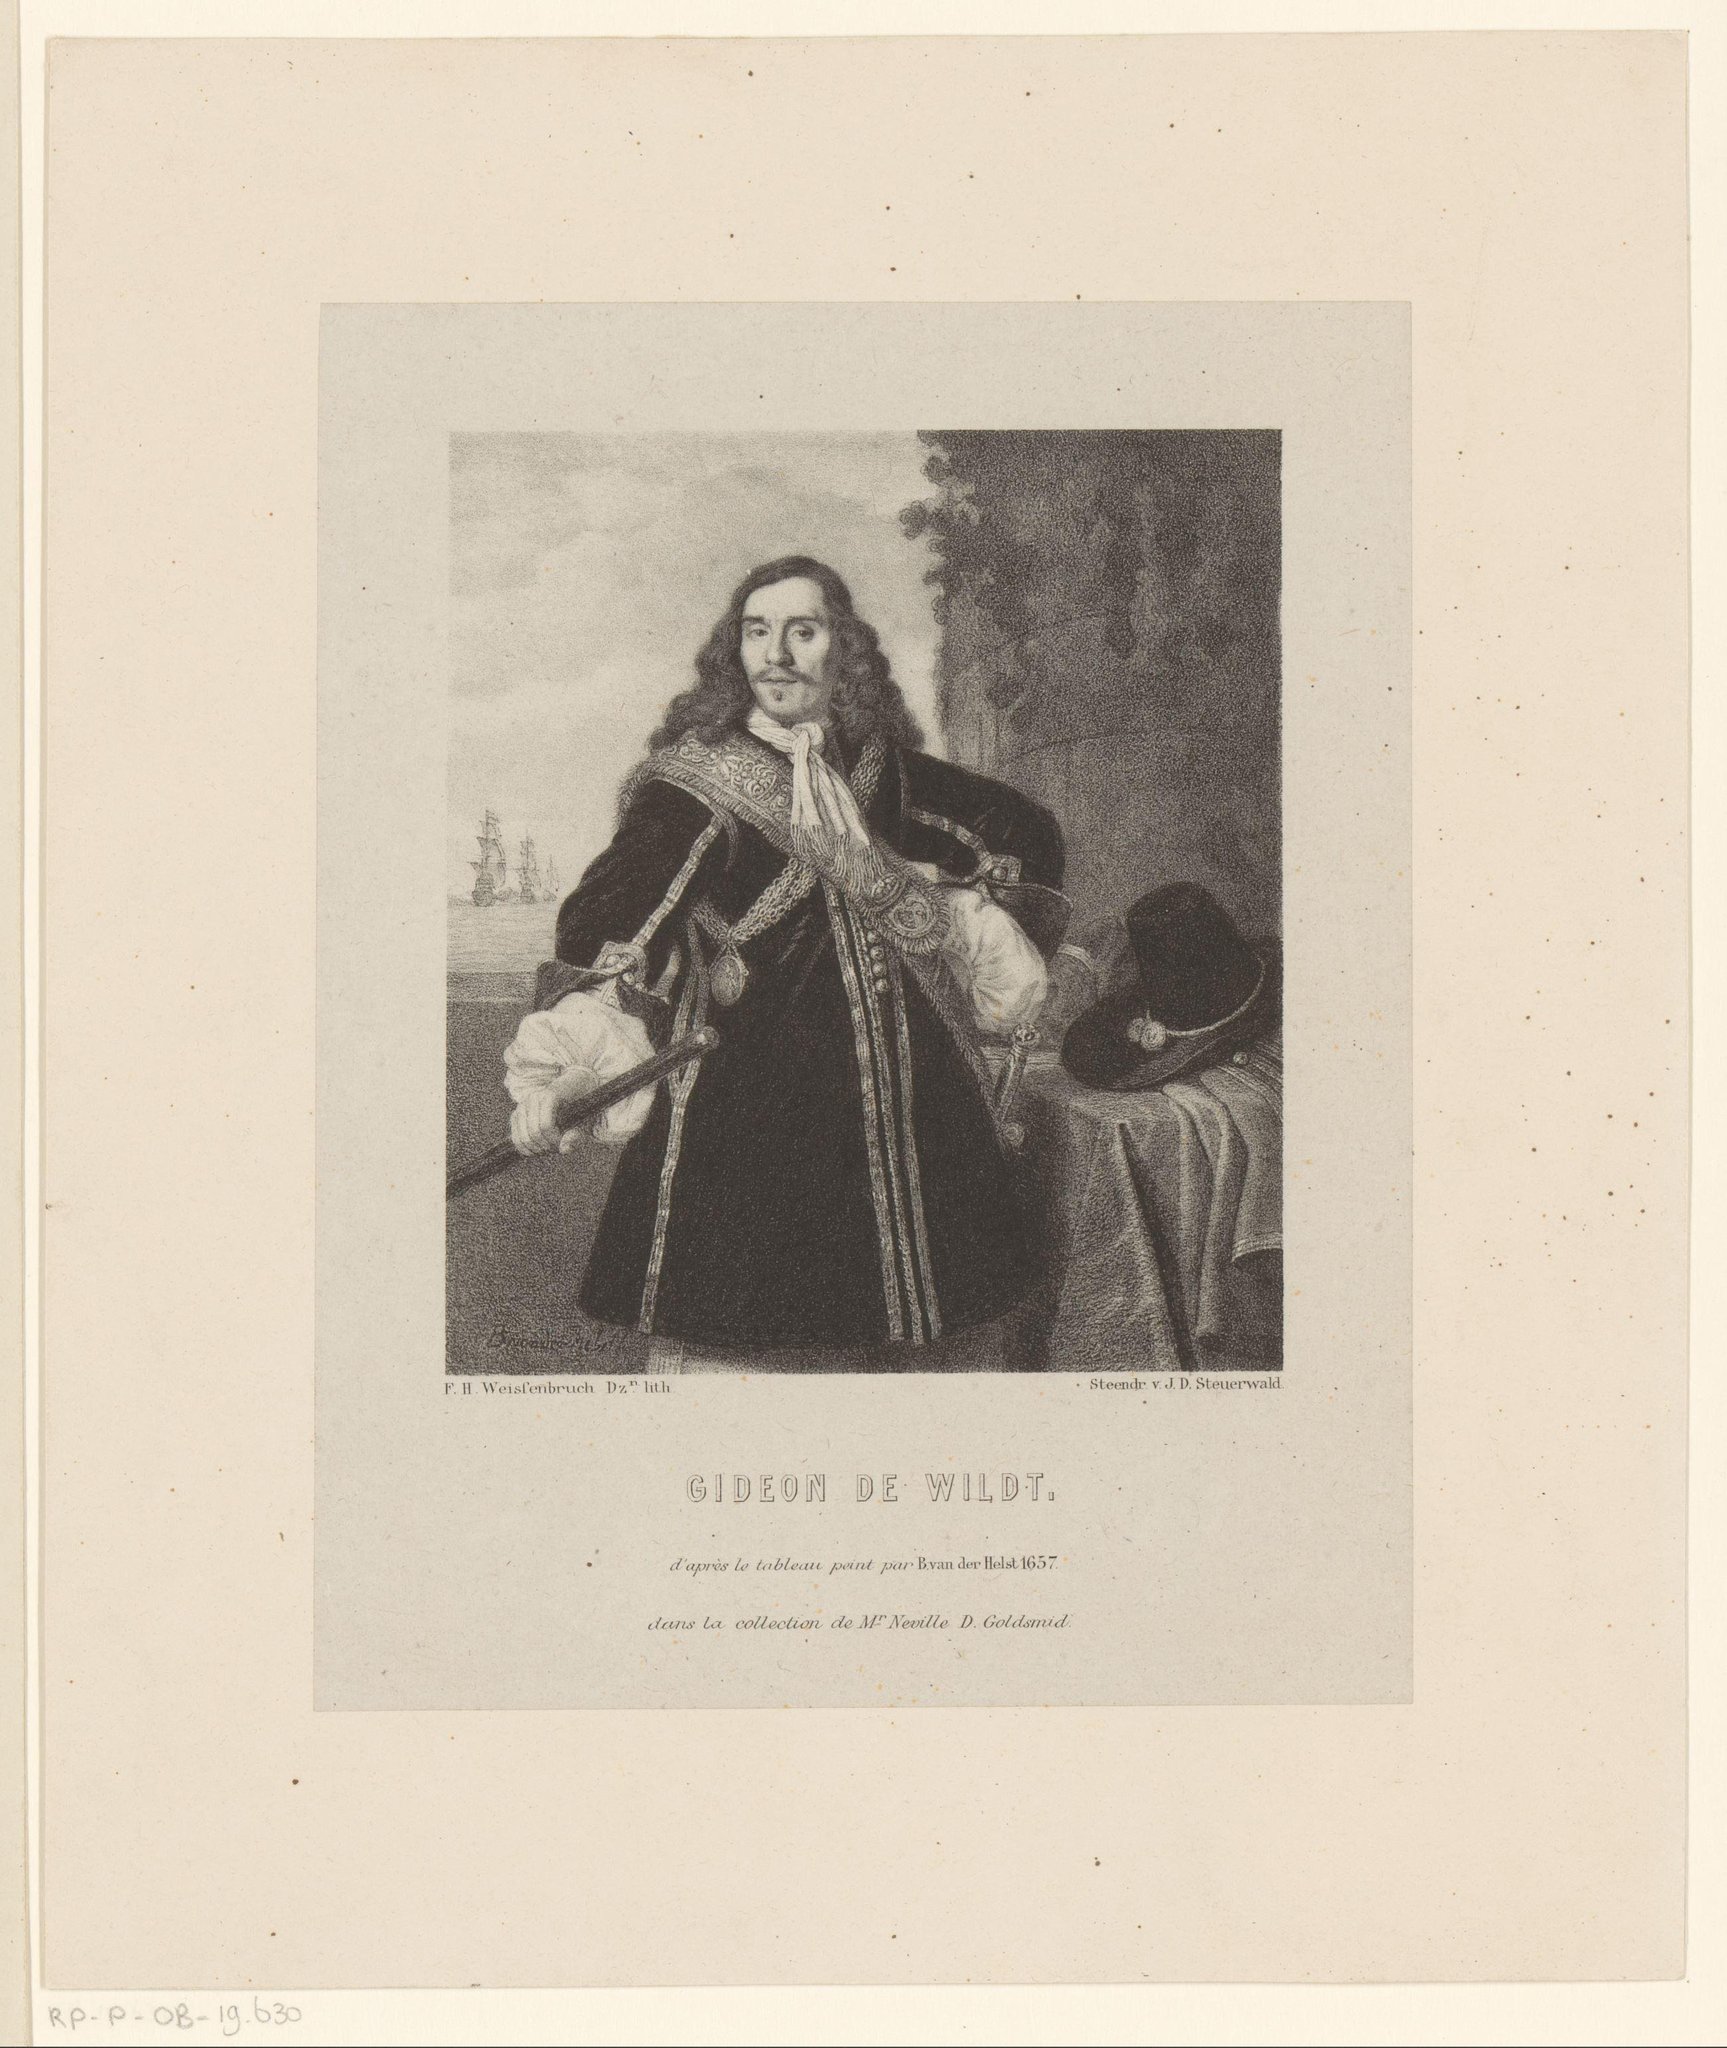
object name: print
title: Gideon de Wildt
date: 1866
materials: paper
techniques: lithograph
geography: the hague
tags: historical persons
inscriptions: collector's mark: Lugt 2228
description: Prent uit Kunstkronijk, 1866 en De Nederlandsche Spectator, 1866. Naar Kapitein Gideon de Wildt (1657) van Bartholomeus van der Helst in het Szépmüvészeti Múzeum te Boedapest.